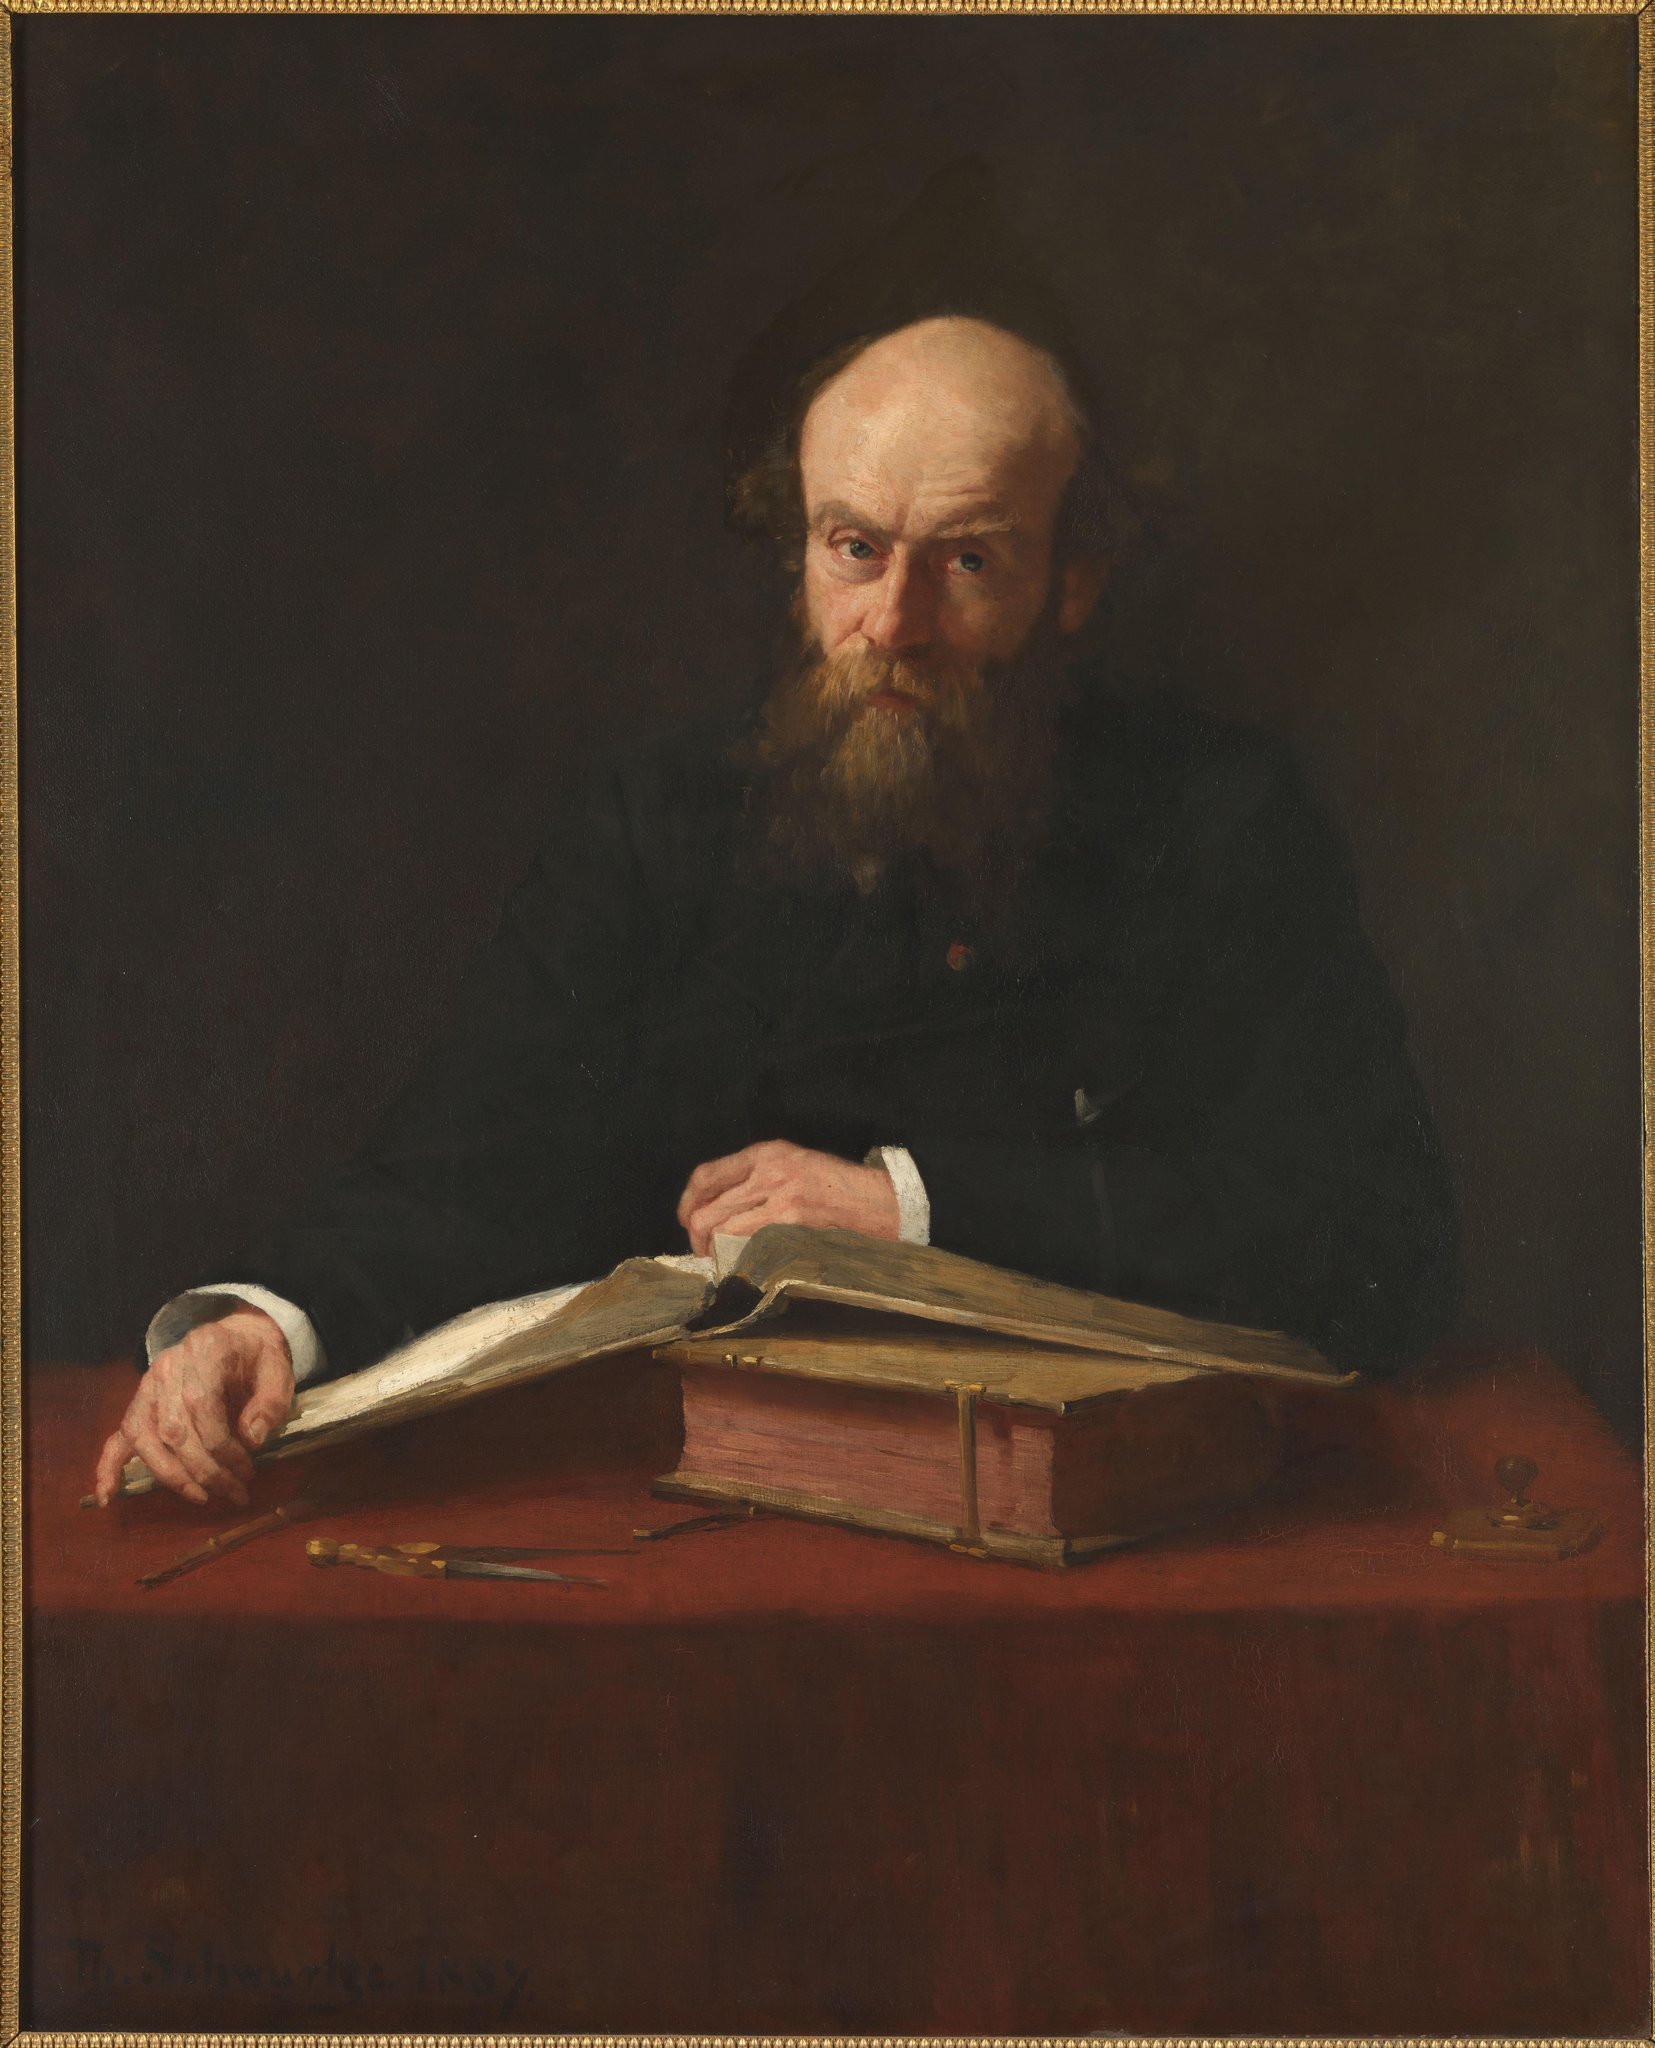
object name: painting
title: Portret van Dr. P.J.H. Cuypers (1827-1921)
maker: thérèse schwartze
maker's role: draughtsman, painter, print maker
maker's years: 1851-1918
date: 1885-1918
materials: canvas, oil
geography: netherlands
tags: draughtsman, pierre joseph hubert cuypers, portrait, self-portrait of architect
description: Portret van de architect Pierre Joseph Hubert Cuypers (1827-1921), gezeten achter een bureau, de handen op een opengeslagen boek.